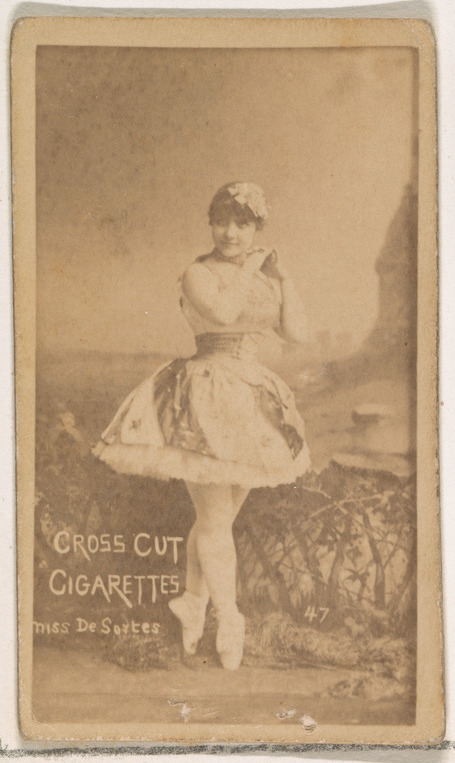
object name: print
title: Card Number 47, Miss De Sortes, from the Actors and Actresses series (N145-1) issued by Duke Sons & Co. to promote Cross Cut Cigarettes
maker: w. duke, sons & co.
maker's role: publisher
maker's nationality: american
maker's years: 1870-1920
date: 1880-1889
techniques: albumen silver print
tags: portraits,women,dancers,ballet